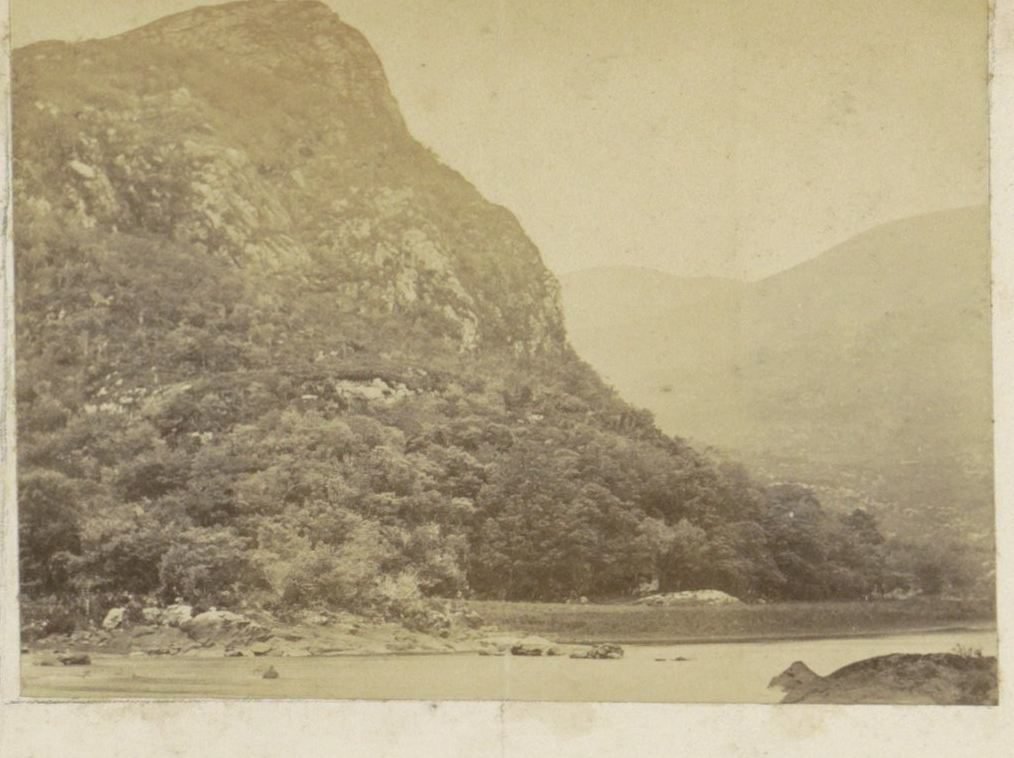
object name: photograph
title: Berglandschap met een rivier in Engeland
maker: Anonymous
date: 1850-1870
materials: paper, photographic support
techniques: albumen print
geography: england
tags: mountains (+ landscape with figures, staffage), england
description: Onderdeel van Album met foto's van bezienswaardigheden en landschappen in Engeland en van kunst.